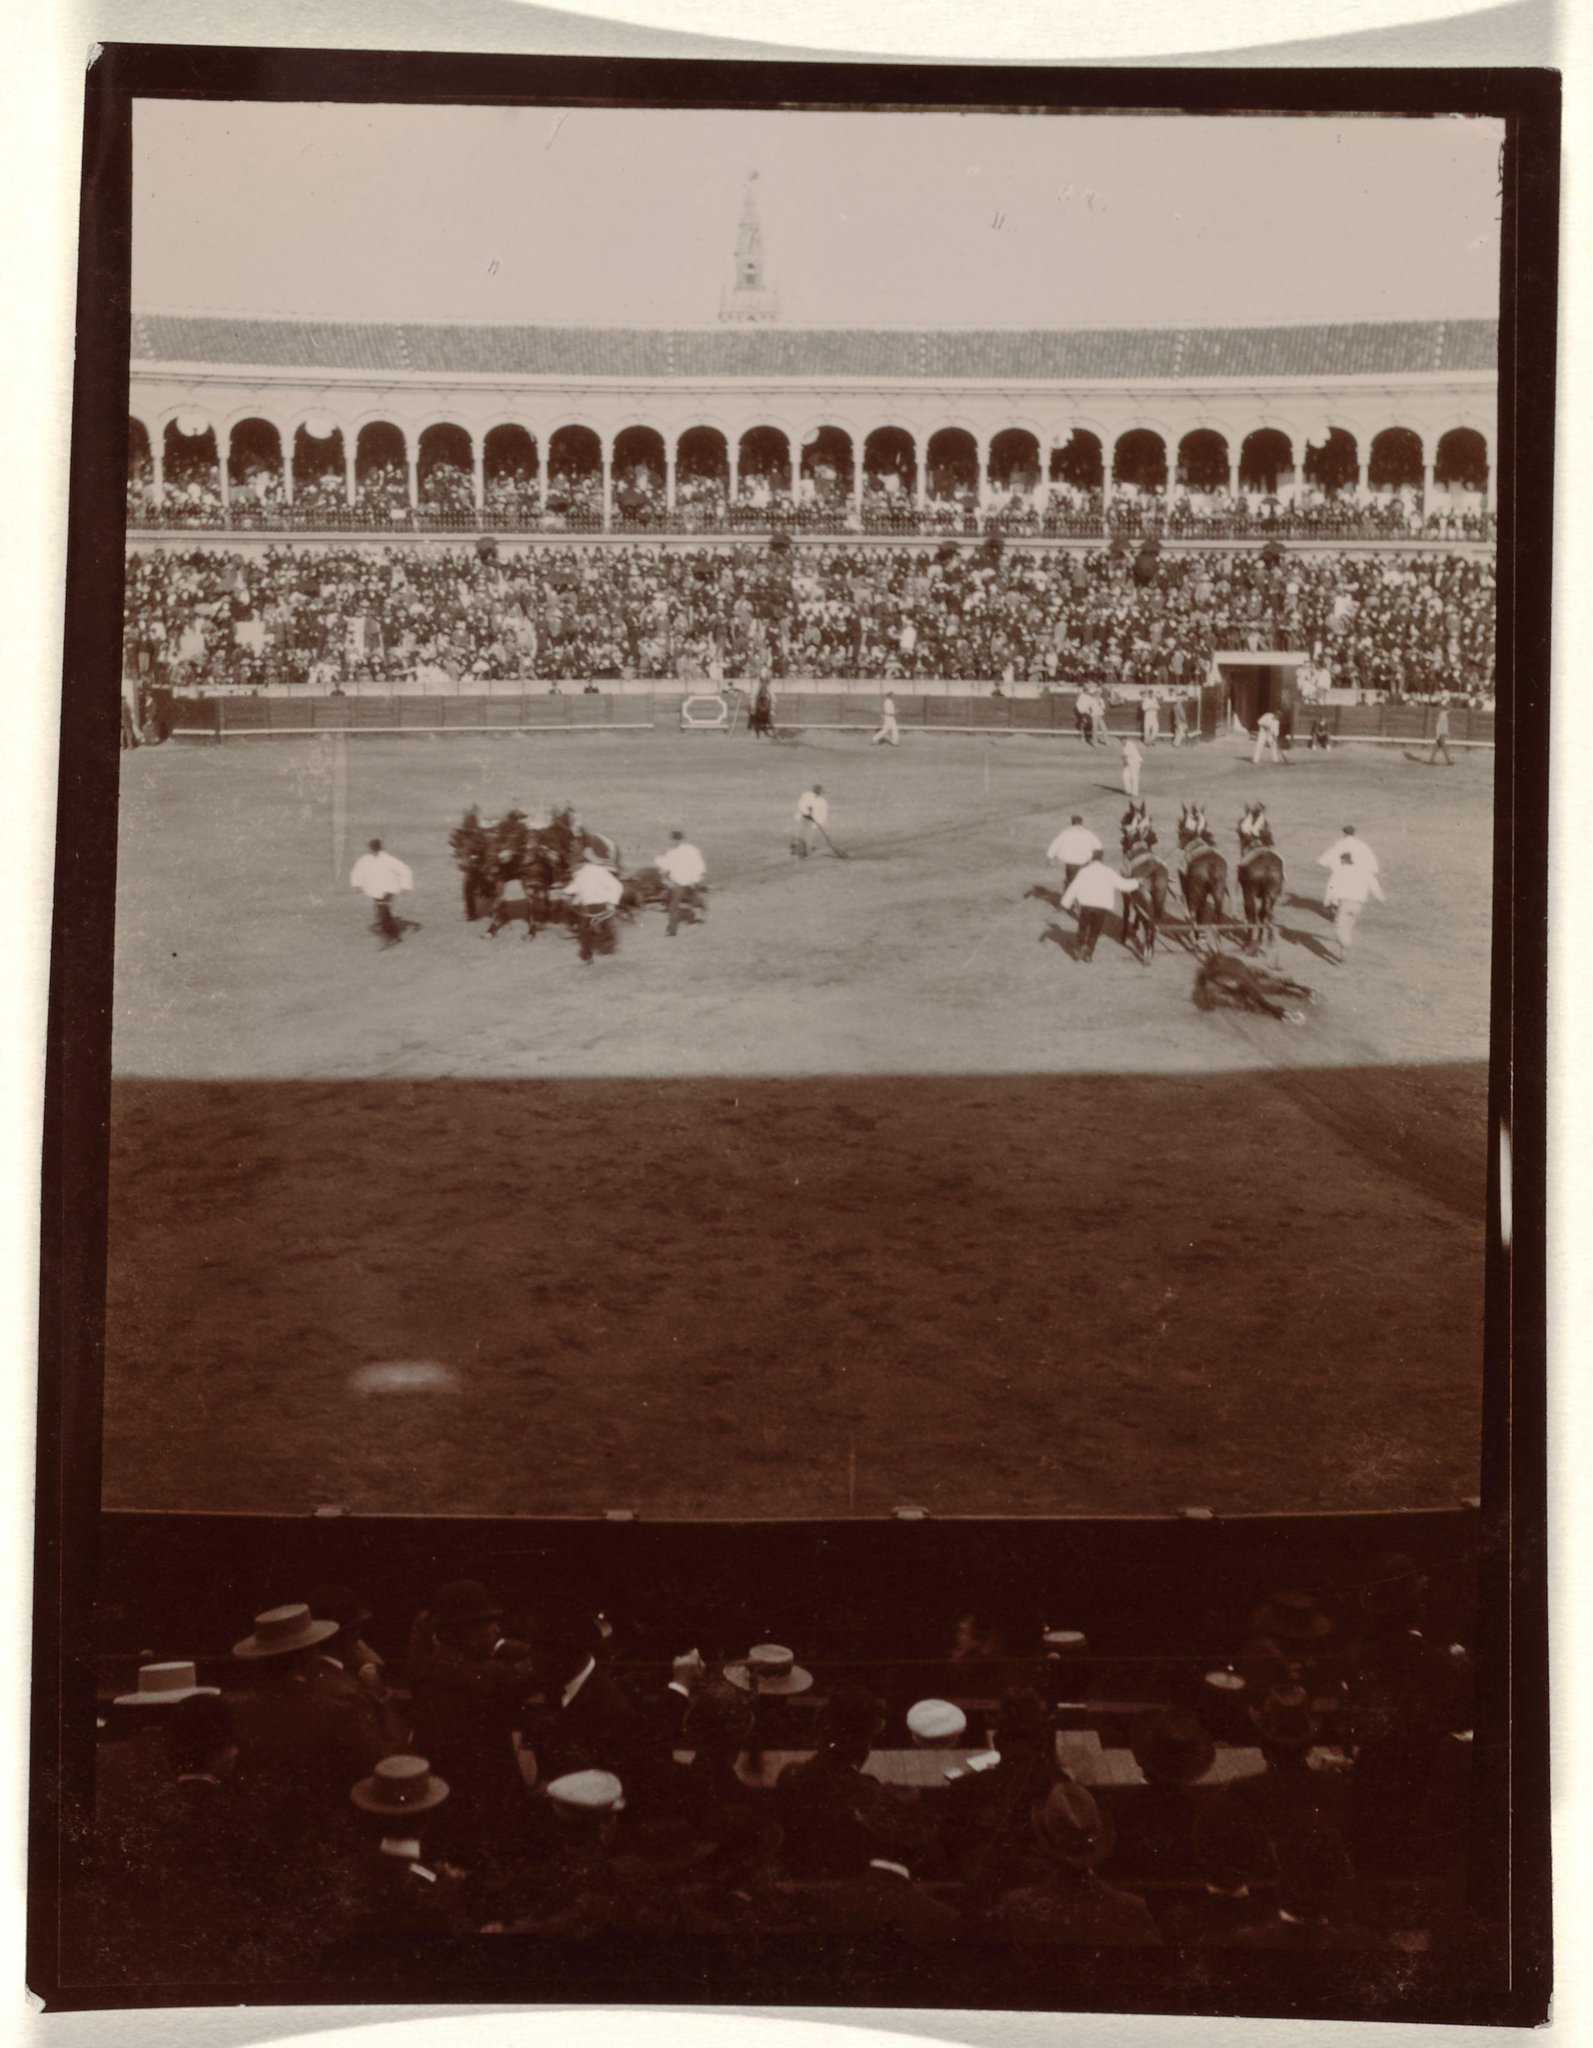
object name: photograph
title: At the Bull Fight, Spain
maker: Anonymous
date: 1905-1922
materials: photographic support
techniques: gelatin silver print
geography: spain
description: Arena voor stierengevechten in Valencia of Barcelona.